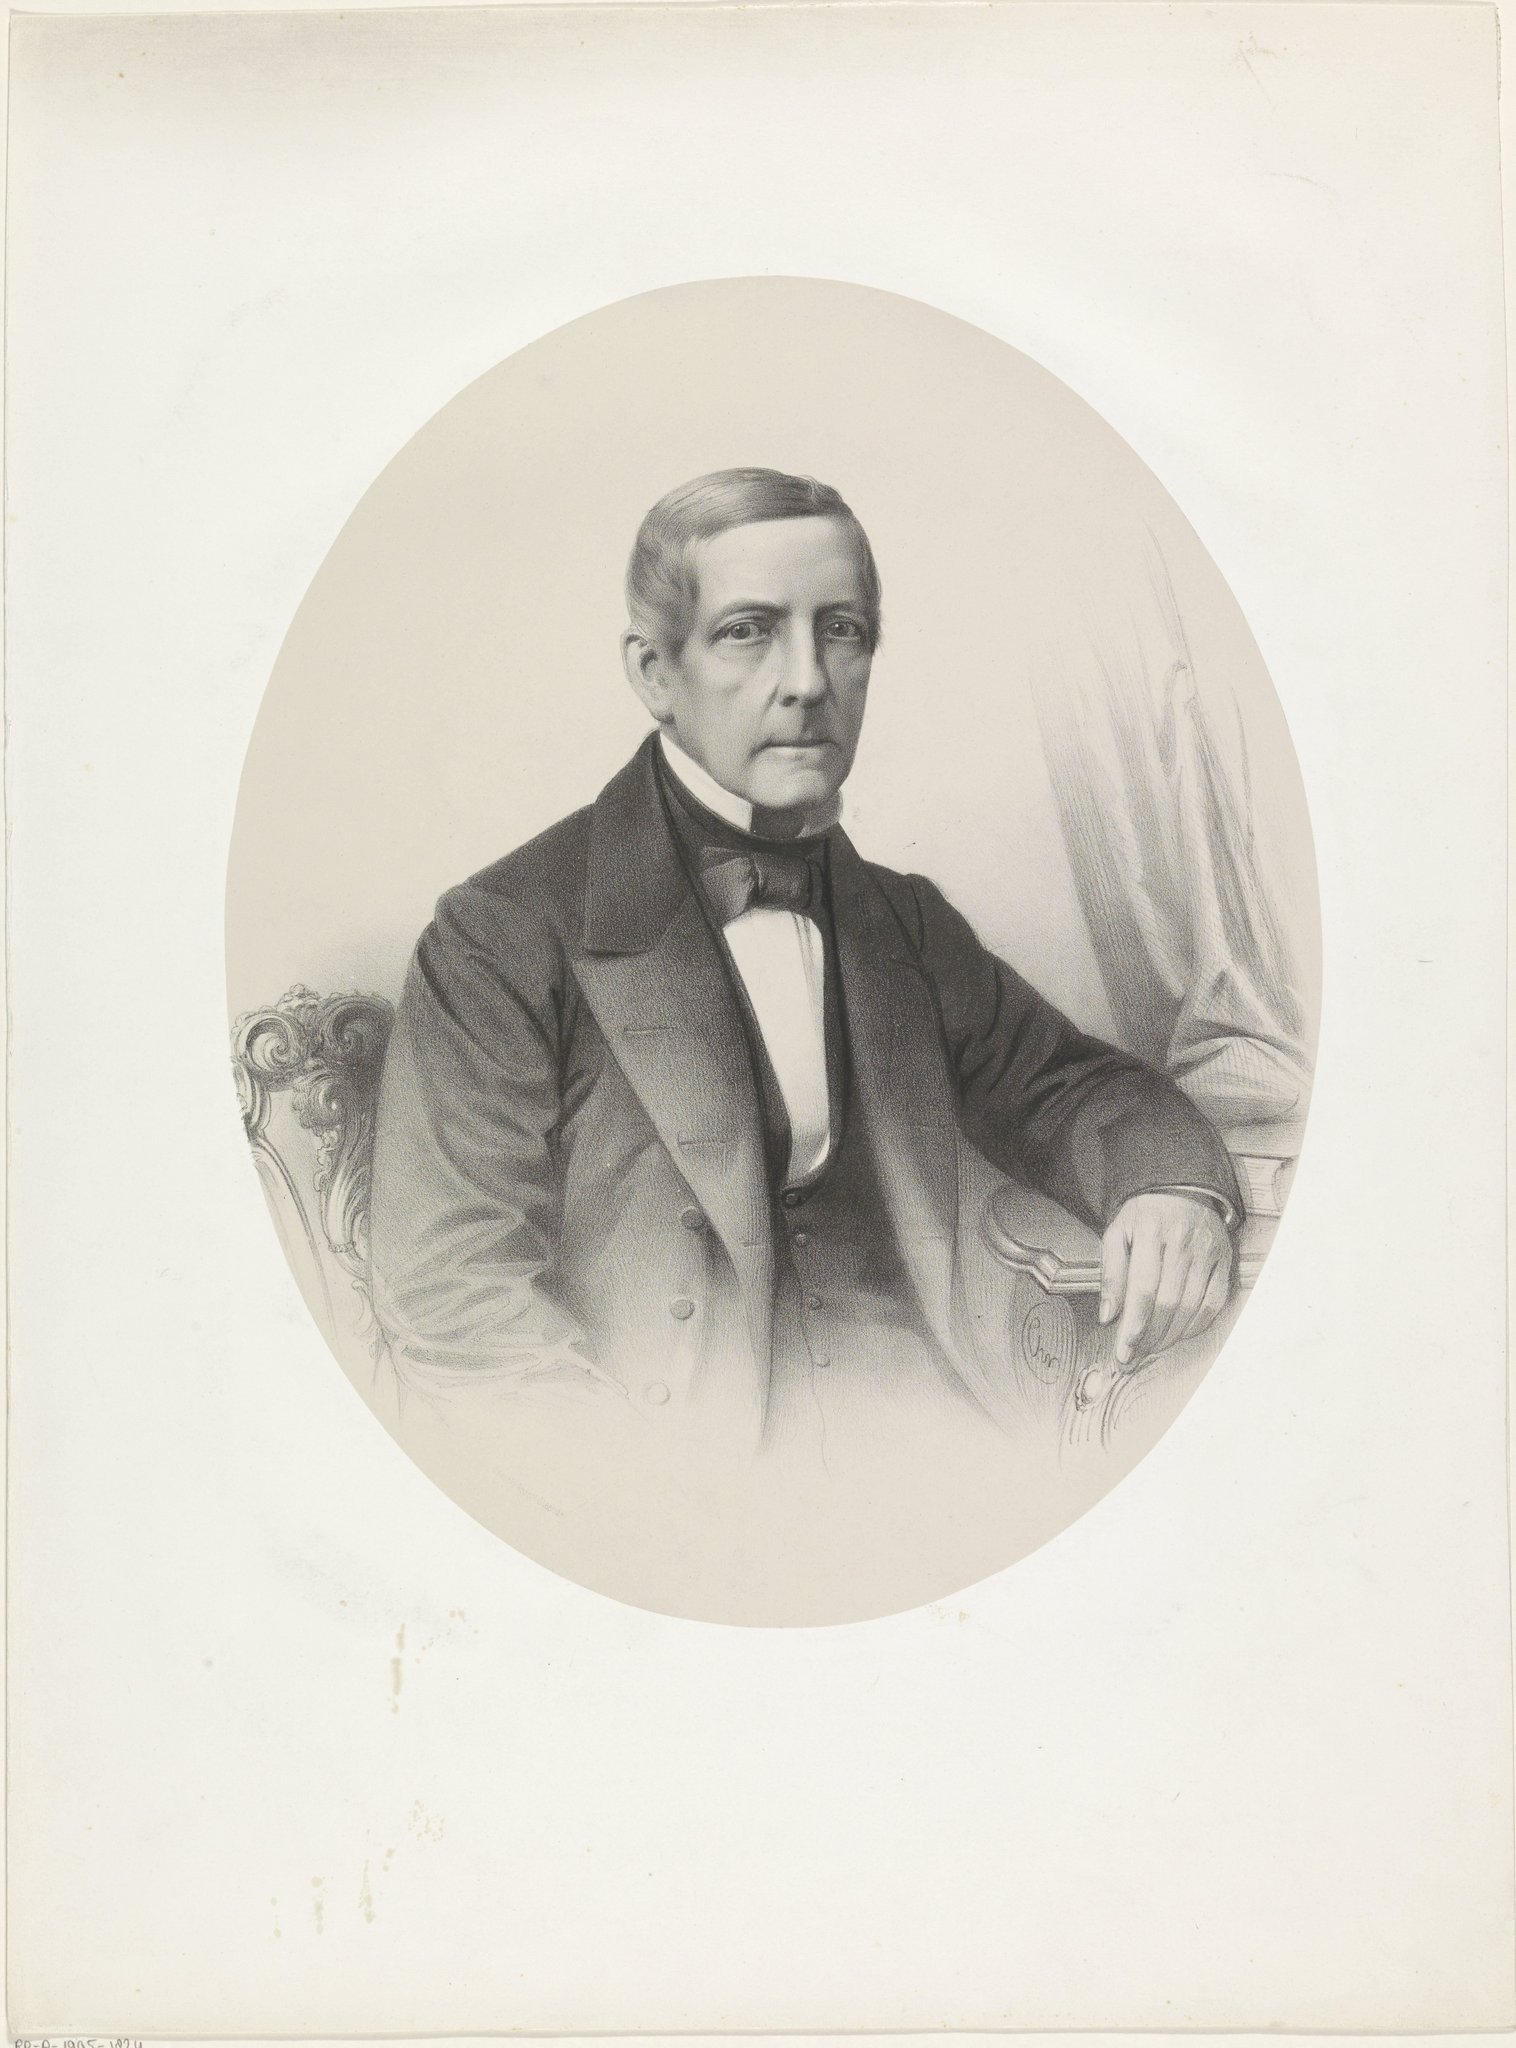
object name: print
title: Portret van Guillaume Groen van Prinsterer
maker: wilhelmus cornelis chimaer van oudendorp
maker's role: print maker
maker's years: 1822-1873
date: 1867-1873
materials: paper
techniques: tone lithography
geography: the hague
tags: guillaume groen van prinsterer, historical persons (+ (full) bust portrait)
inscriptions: collector's mark: Lugt 2228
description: De geportretteerde zit op een stoel en leunt met zijn linkerarm op een tafel naast hem. Daarop ligt een boek. Rechts van hem hangt een draperie.